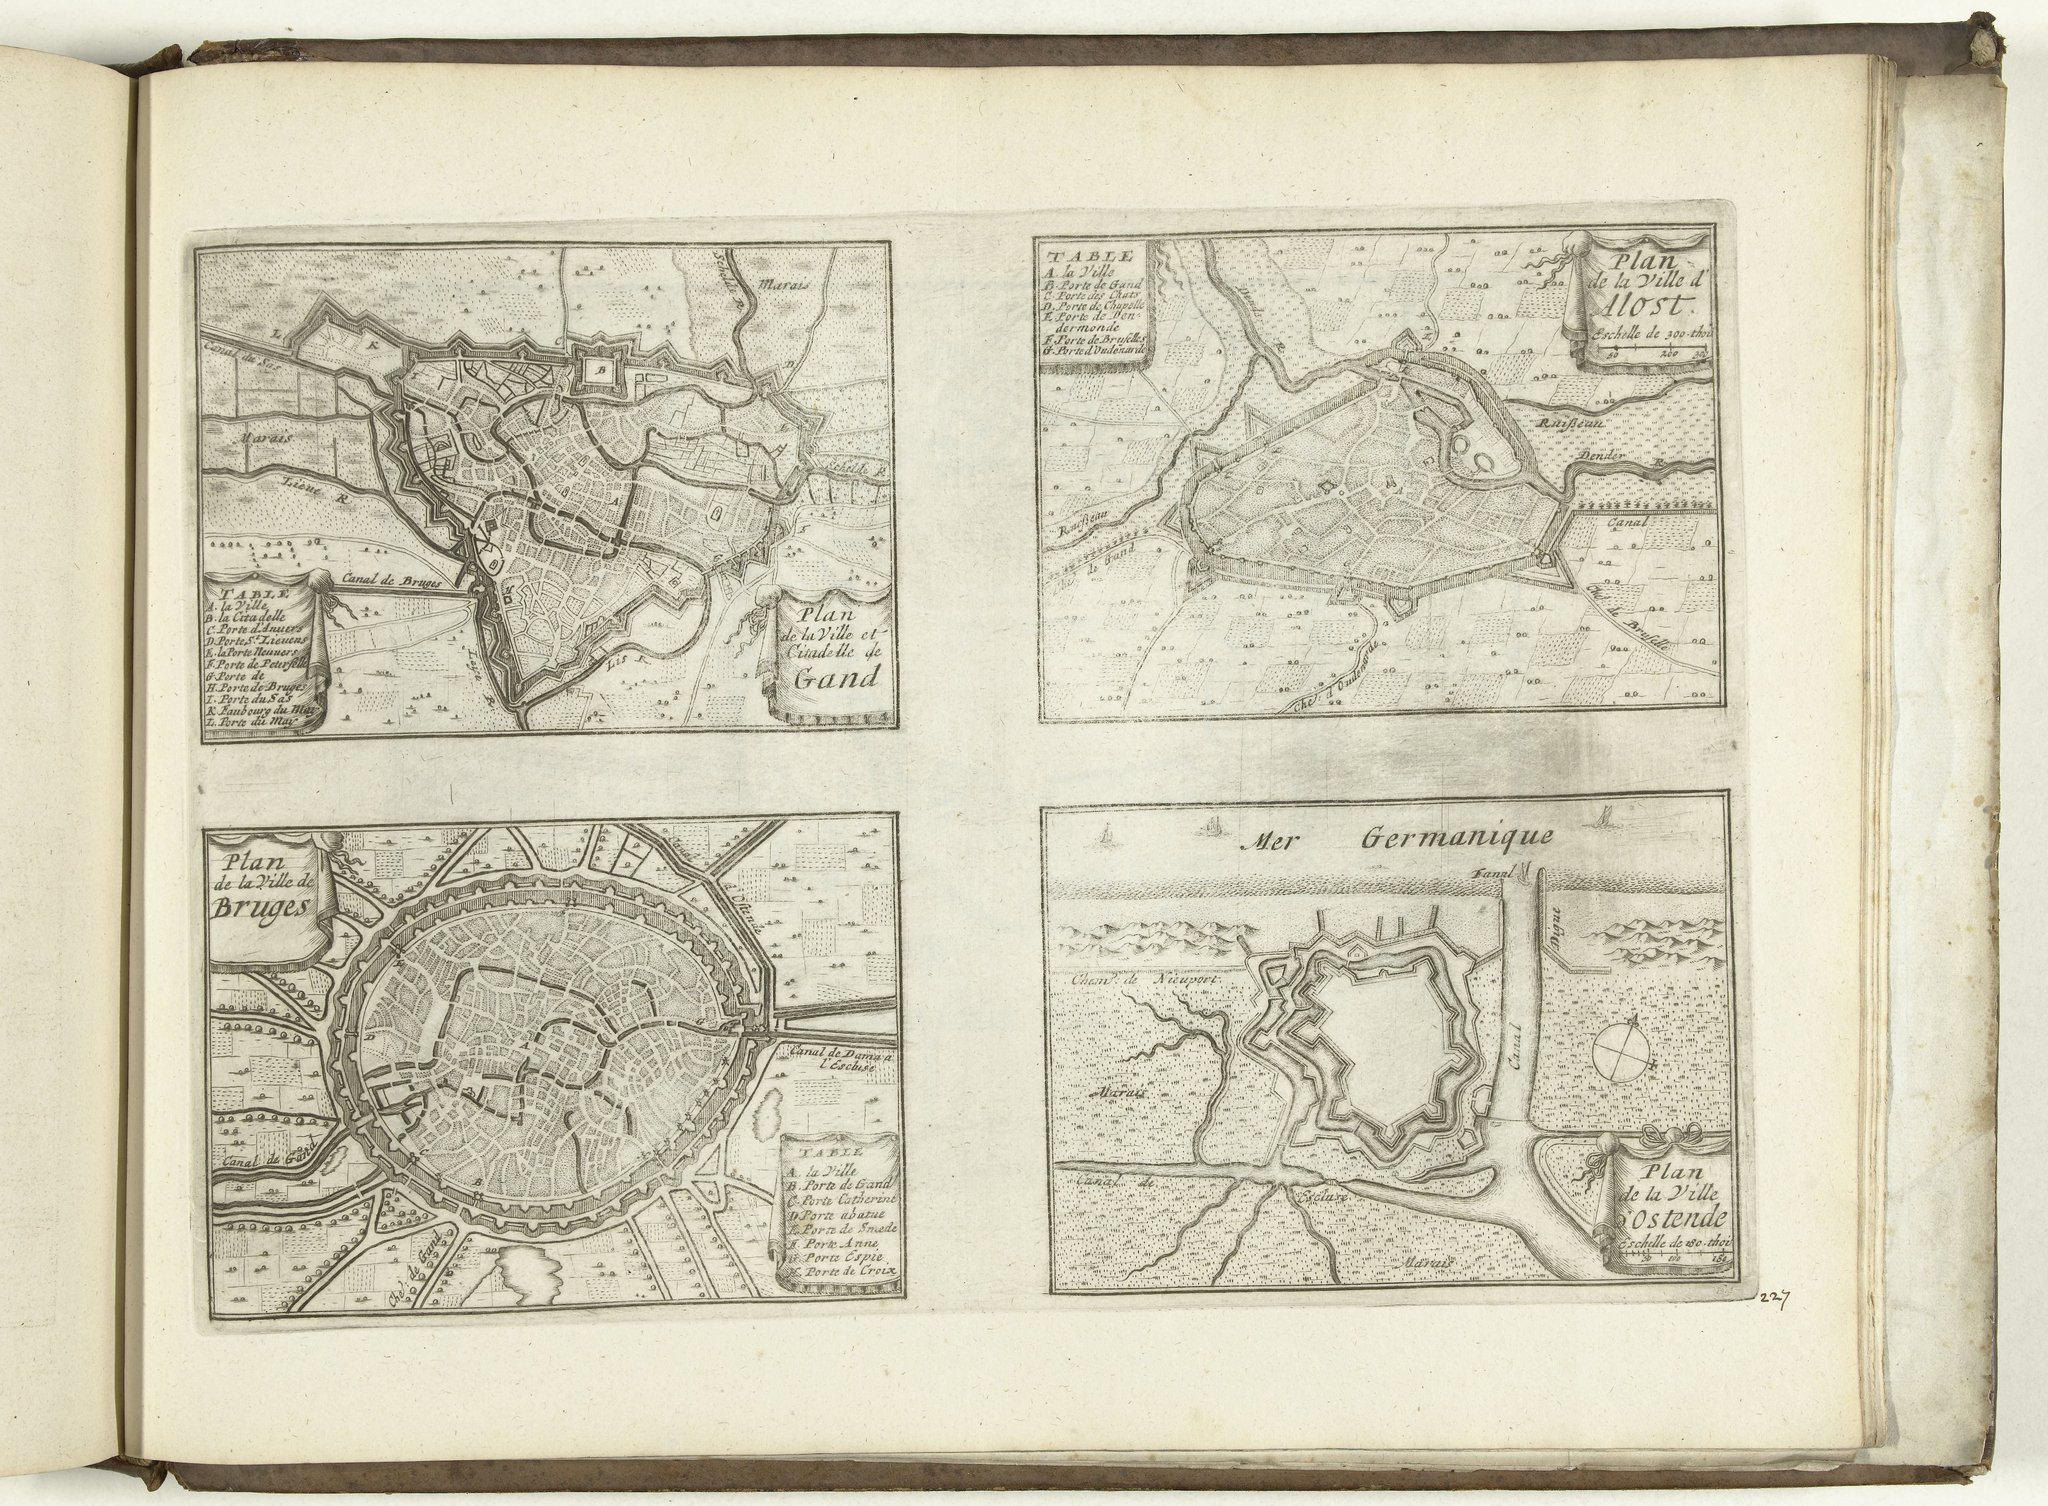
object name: print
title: Gand / Alost / Bruges / Ostende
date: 1726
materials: paper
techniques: engraving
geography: leiden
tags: fortress, maps of cities, ghent, bruges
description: Blad met vier plattegronden van de verdedigingswerken om de Vlaamse steden Gent, Aalst, Brugge en Oostende. Plaat nr. 227 in deel X van het prentwerk: Les Forces de l'Europe, Asie, Afrique et Amerique ... Comme aussi les Cartes des Côtes de France et d'Espagne uit 1726, dit eerste deel met 238 met de hand genummerde platen van vermaarde sterke steden en vestingen in het kader van de Spaanse Successieoorlog 1701-1713. Voor het merendeel zijn deze platen gekopieerd naar de anonieme Franse platen van vermaarde sterke steden en vestingen: in Les forces de l'Europe en in: Le theatre de la guerre, dans les Pays-Bas, beide oorspronkelijk uitgegeven door Nicolas de Fer te Parijs (1693-1697) in het kader van de Negenjarige Oorlog. Titels en opschriften in het Frans. Rechtsonder sporen van het weggepolijste nummer: 64.